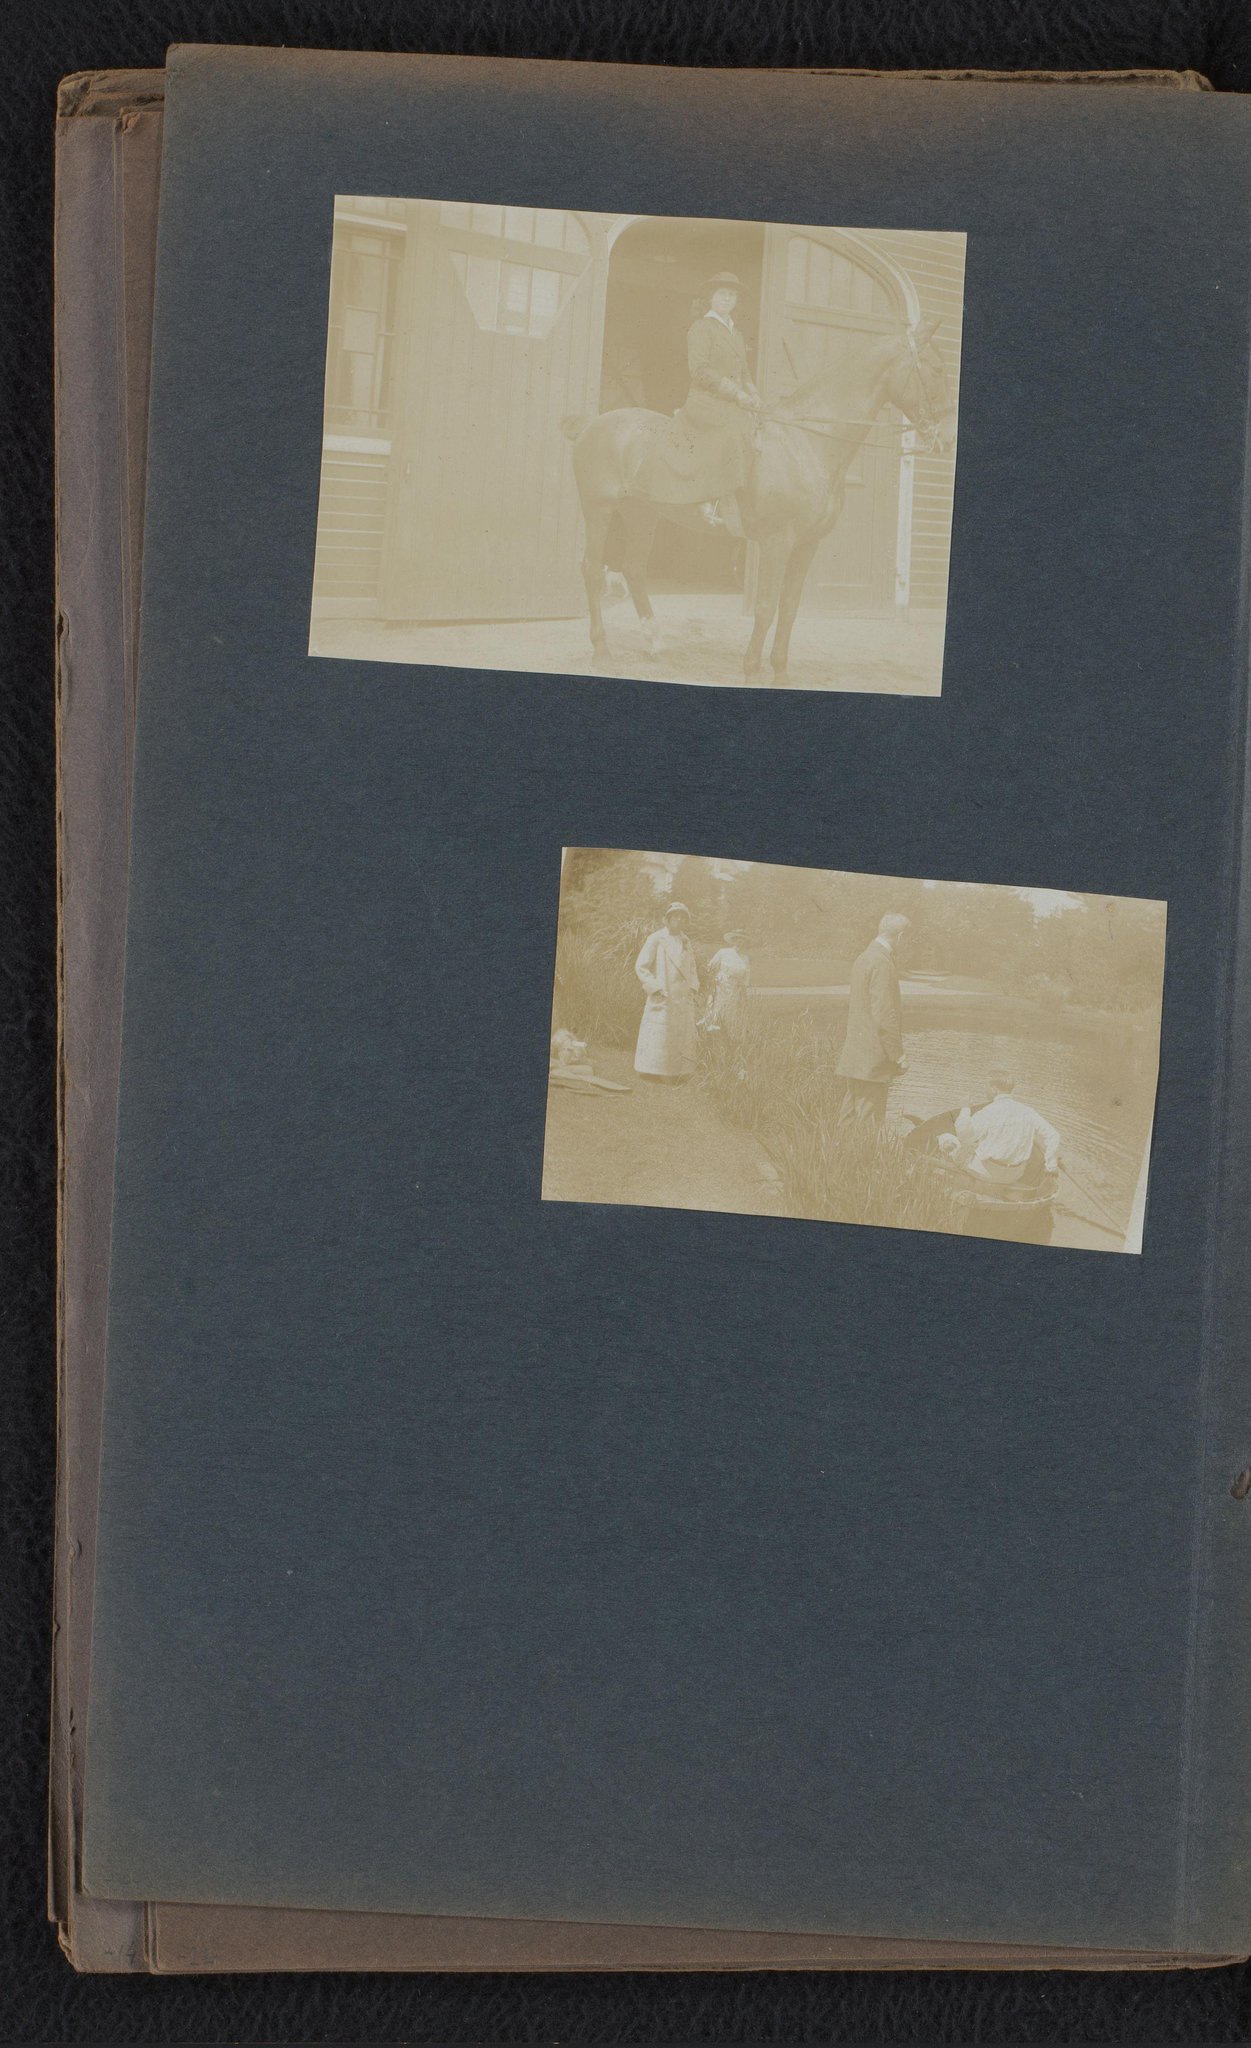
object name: photograph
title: Vrouw te paard, en vier mensen op een kade bij een roeiboot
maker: carolina frederika onnen (lien/loen)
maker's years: 1896-1983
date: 1912-1913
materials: paper, cardboard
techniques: collodion silver print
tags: rowing-boat, canoe, etc., horse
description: Deze foto's zijn onderdeel van een album.